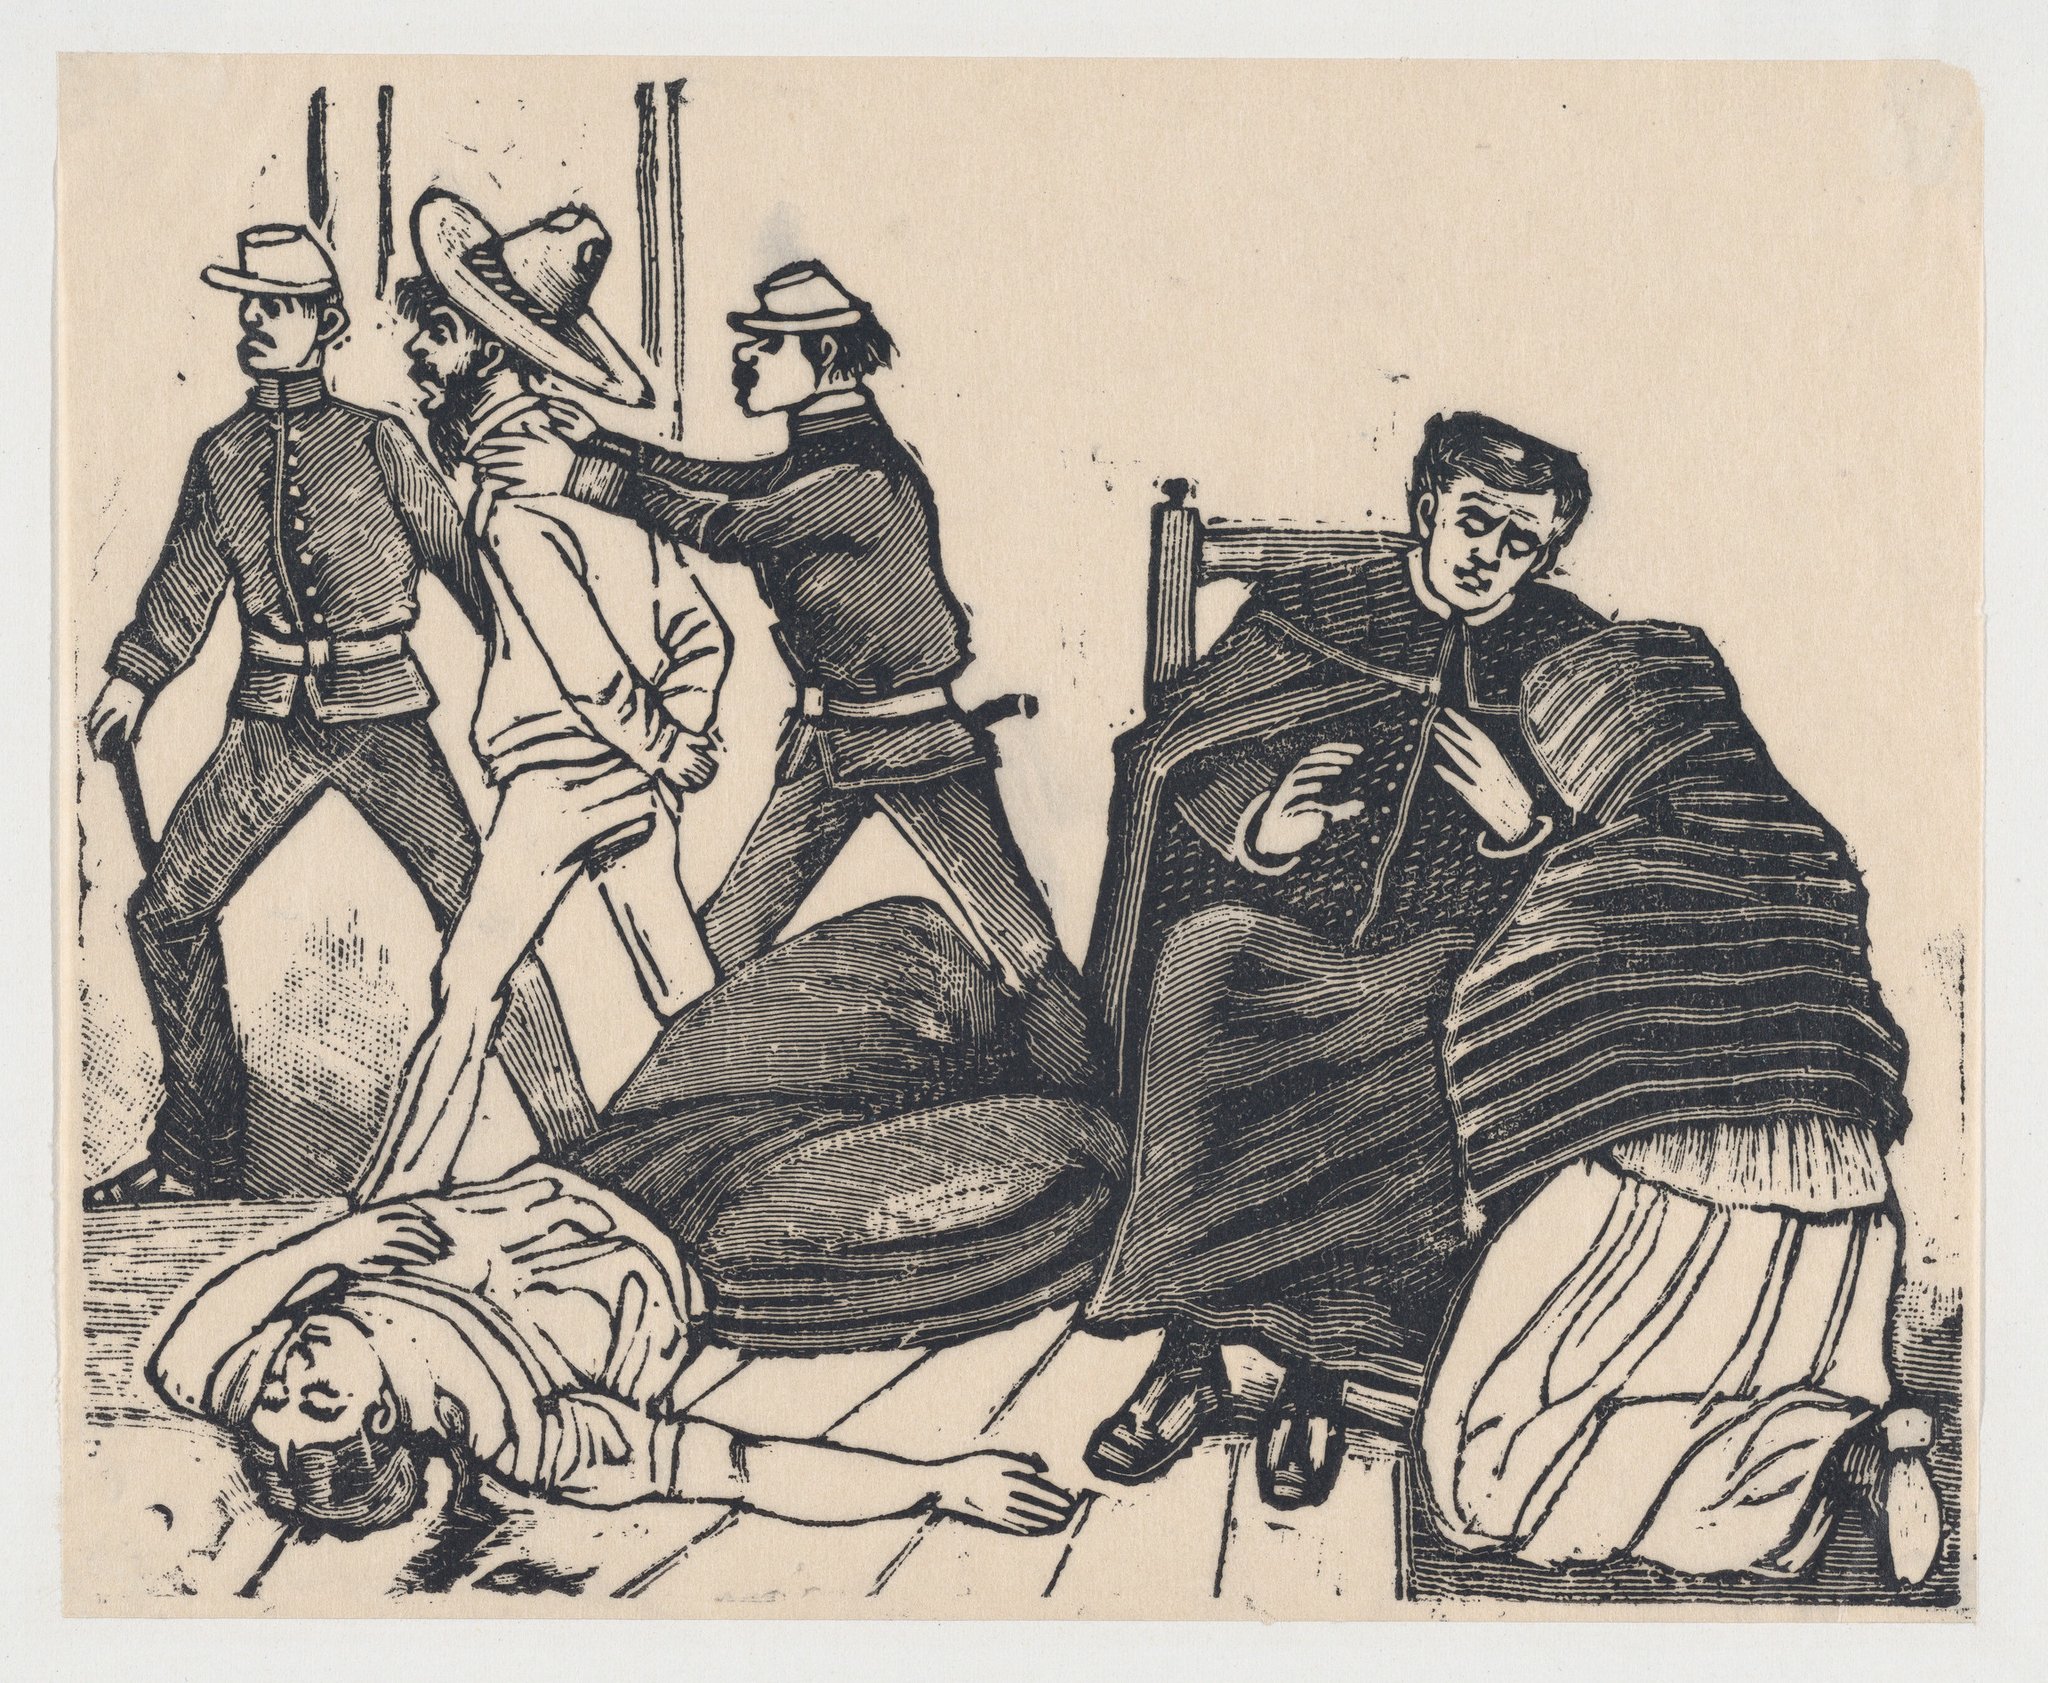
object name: print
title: The double murder in Puente de los Gallos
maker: josé guadalupe posada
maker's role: artist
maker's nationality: mexican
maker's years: 1852-1913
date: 1892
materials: metal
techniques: engraving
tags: men,women,death